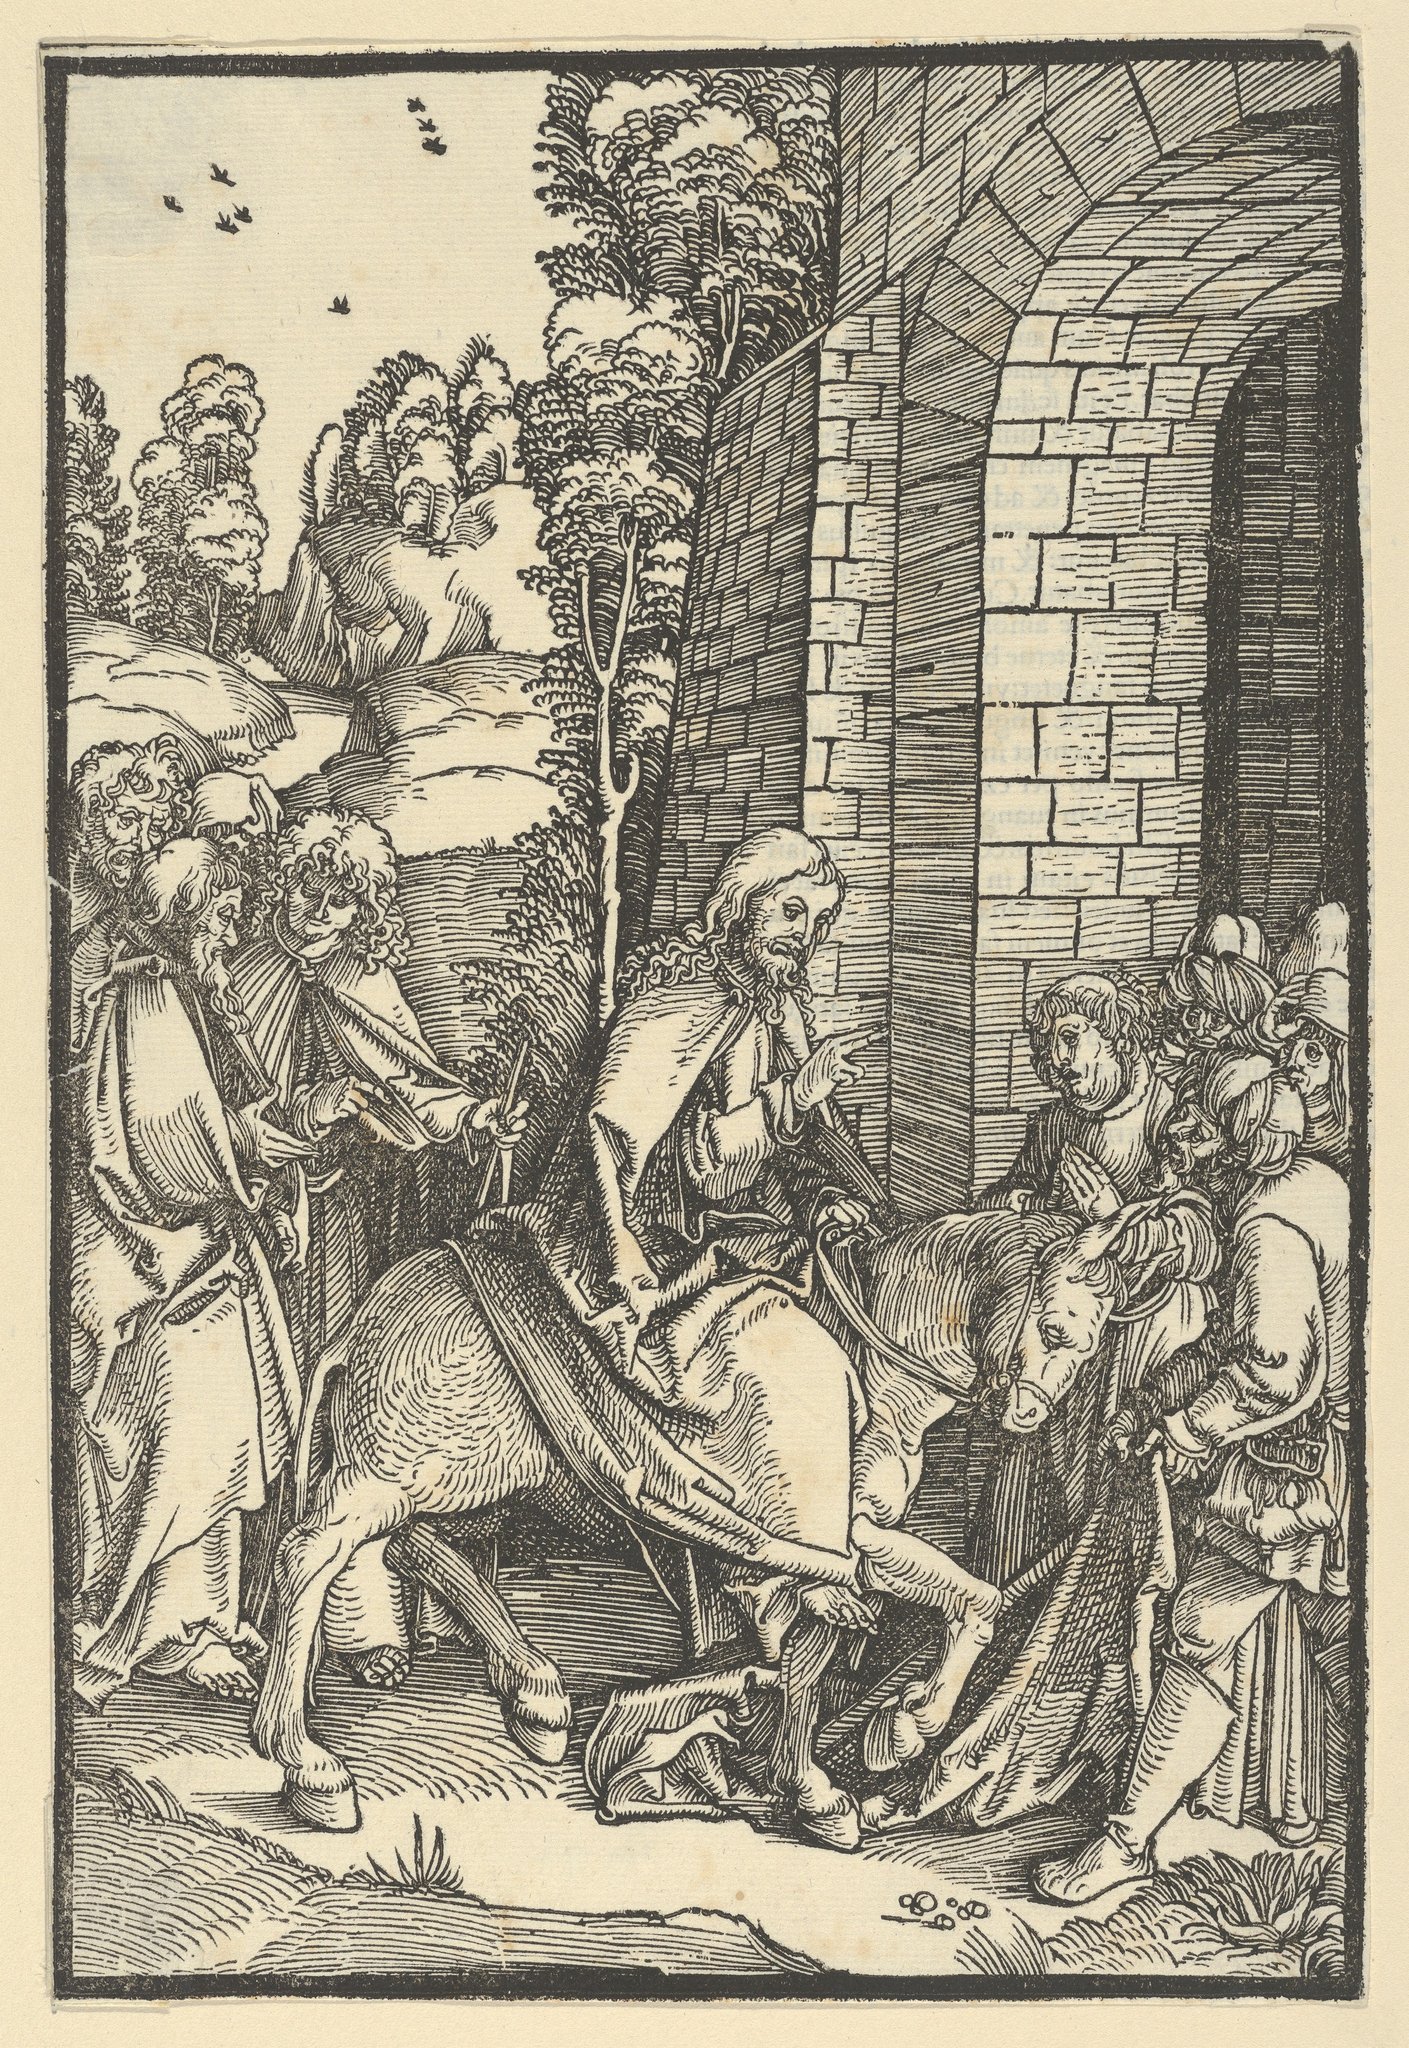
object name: print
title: The Entry into Jerusalem, from Speculum passionis domini nostri Ihesu Christi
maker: hans schäufelein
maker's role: artist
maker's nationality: german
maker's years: 1480-1540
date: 1507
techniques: woodcut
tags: men,women,donkeys,christ